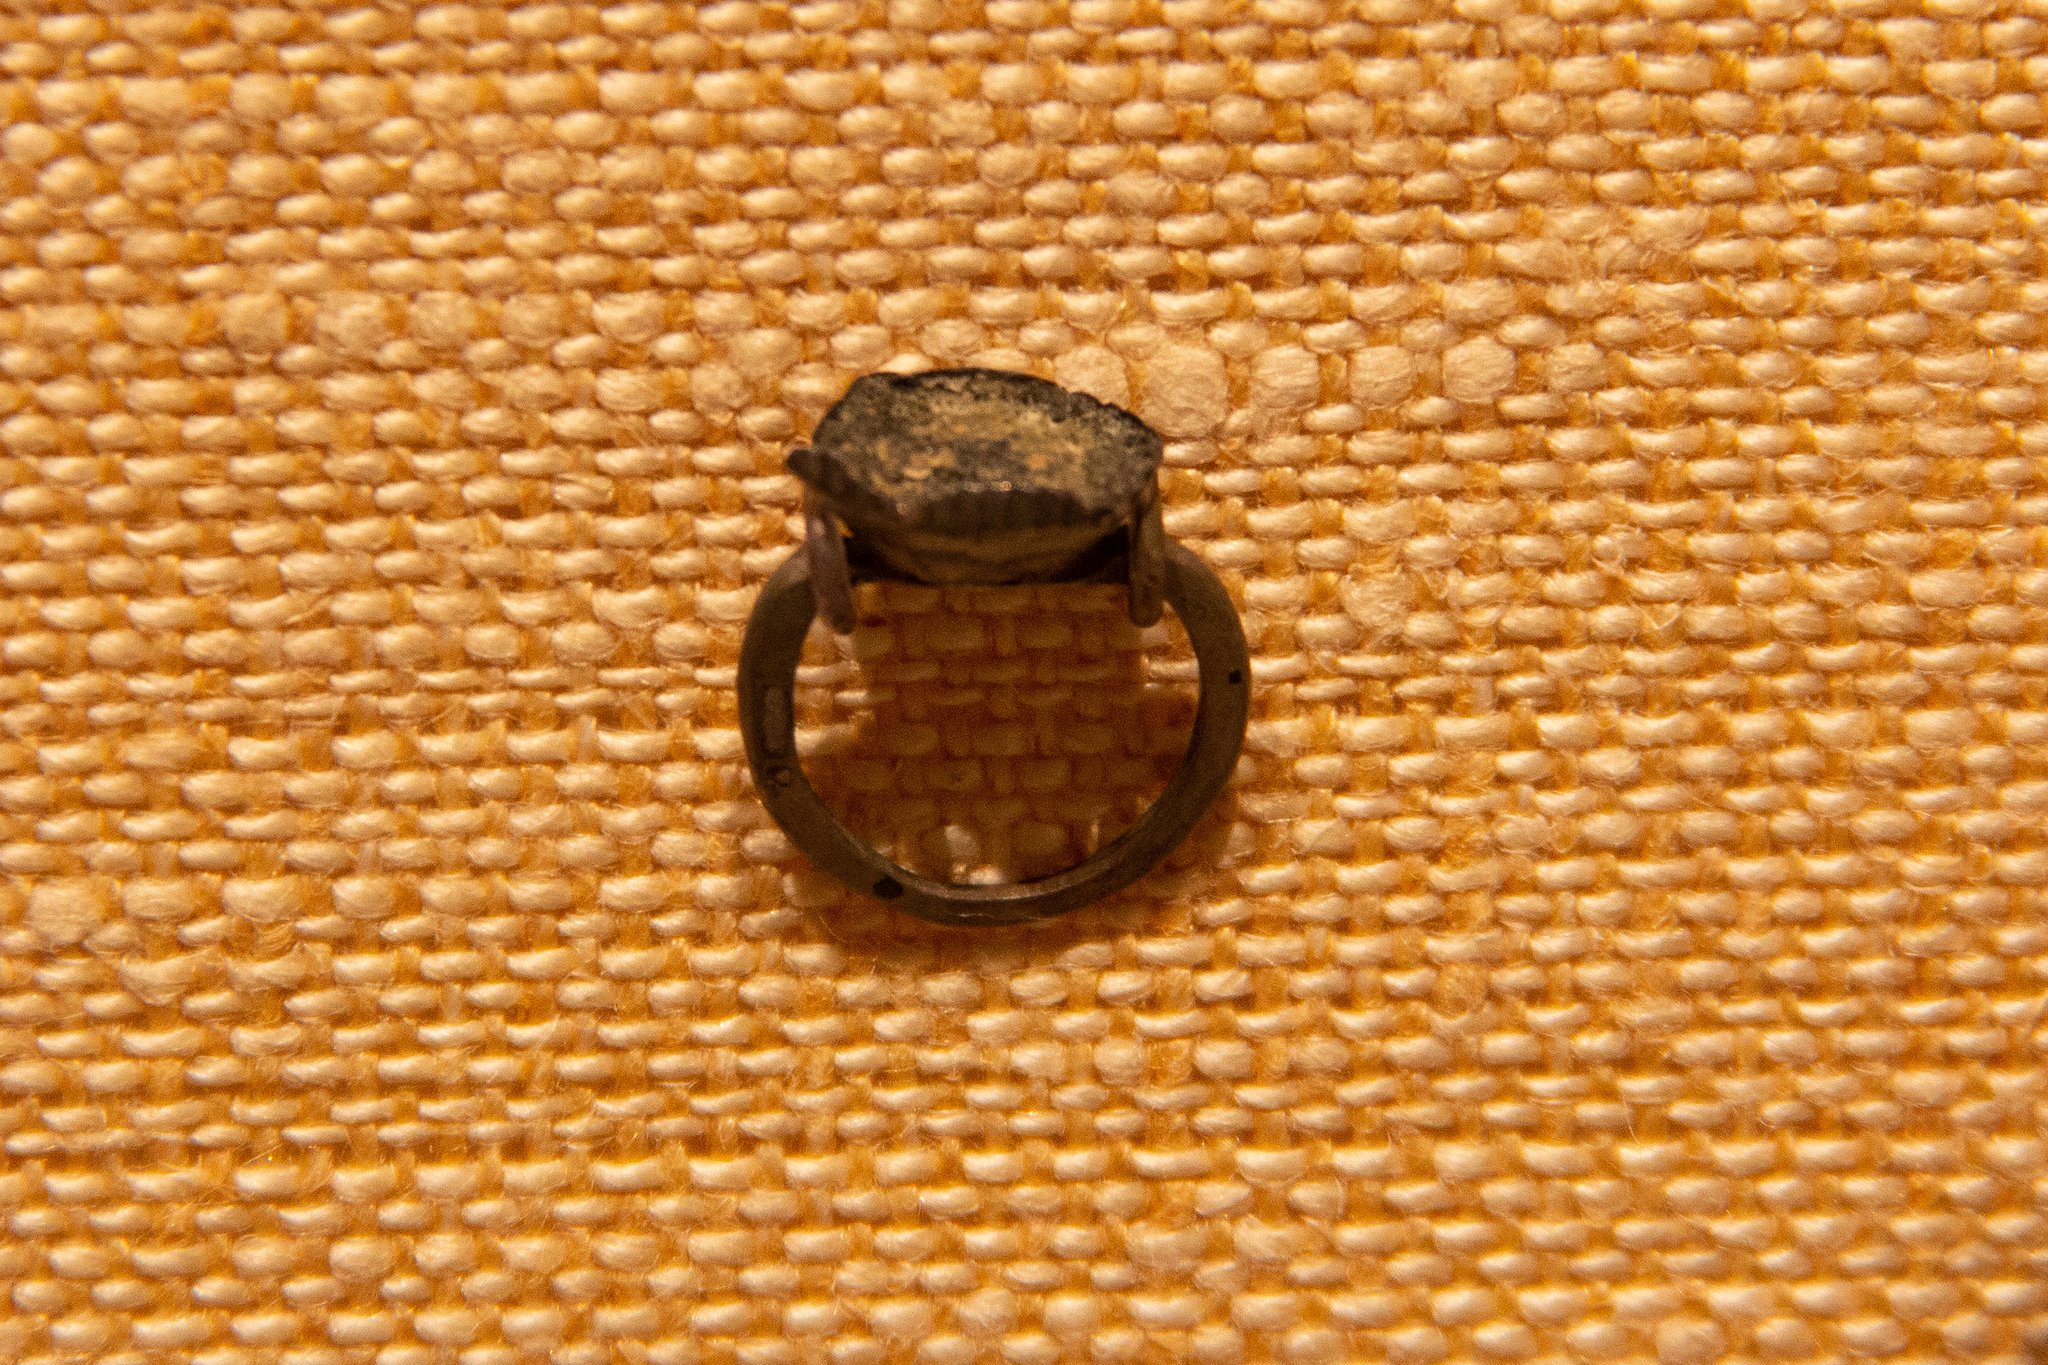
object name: ring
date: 801-1100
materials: silver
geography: iran